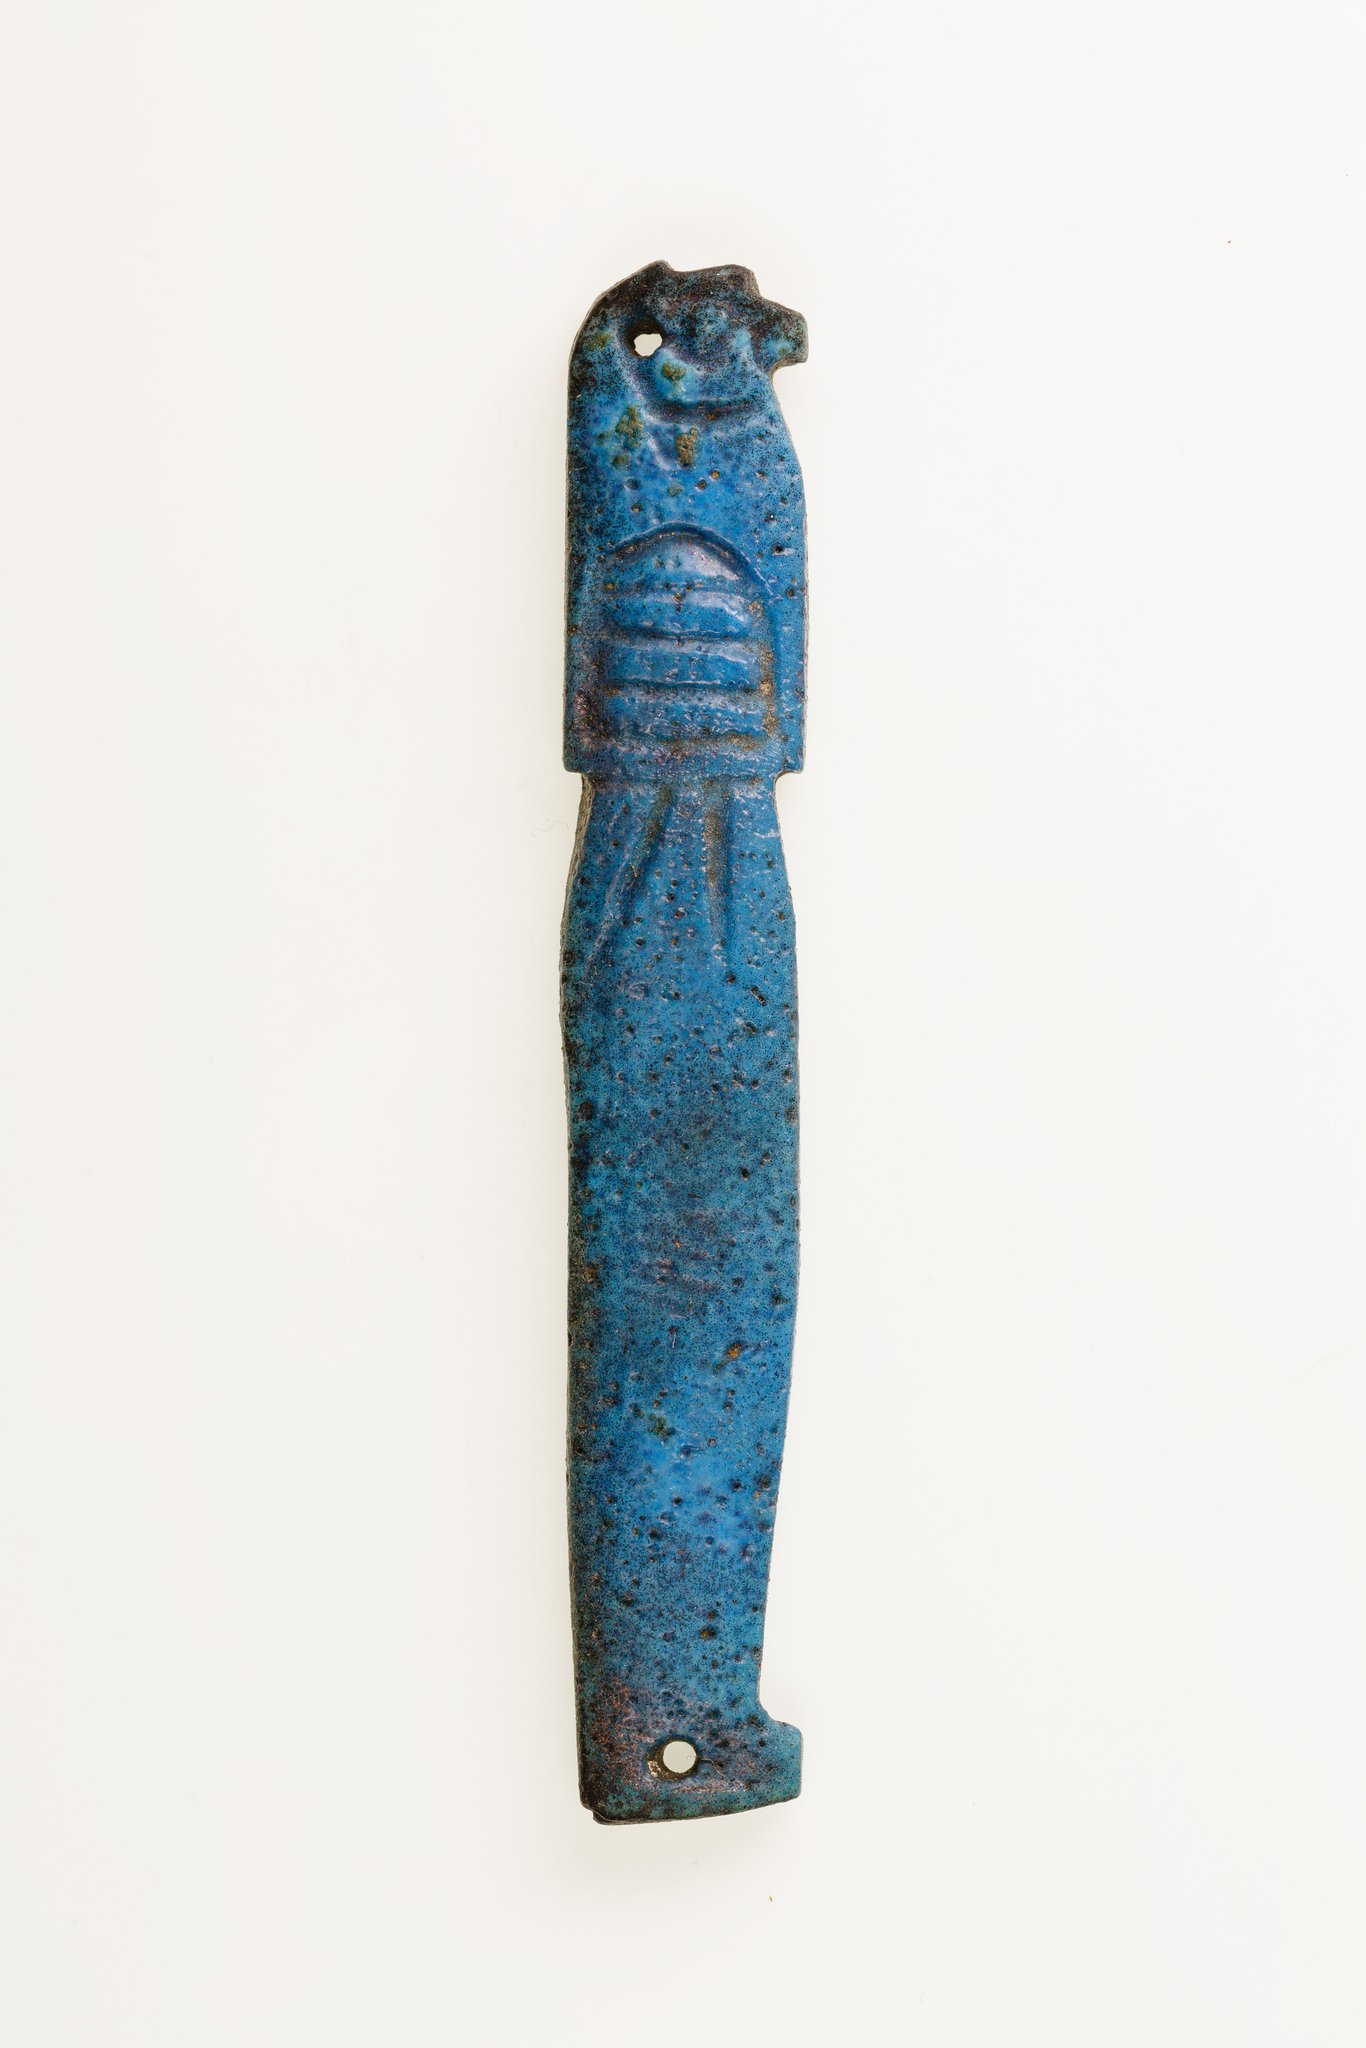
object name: amulet, son of horus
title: Son of Horus ( Hapy) from Bead Net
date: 1070-525 BCE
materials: faience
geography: egypt